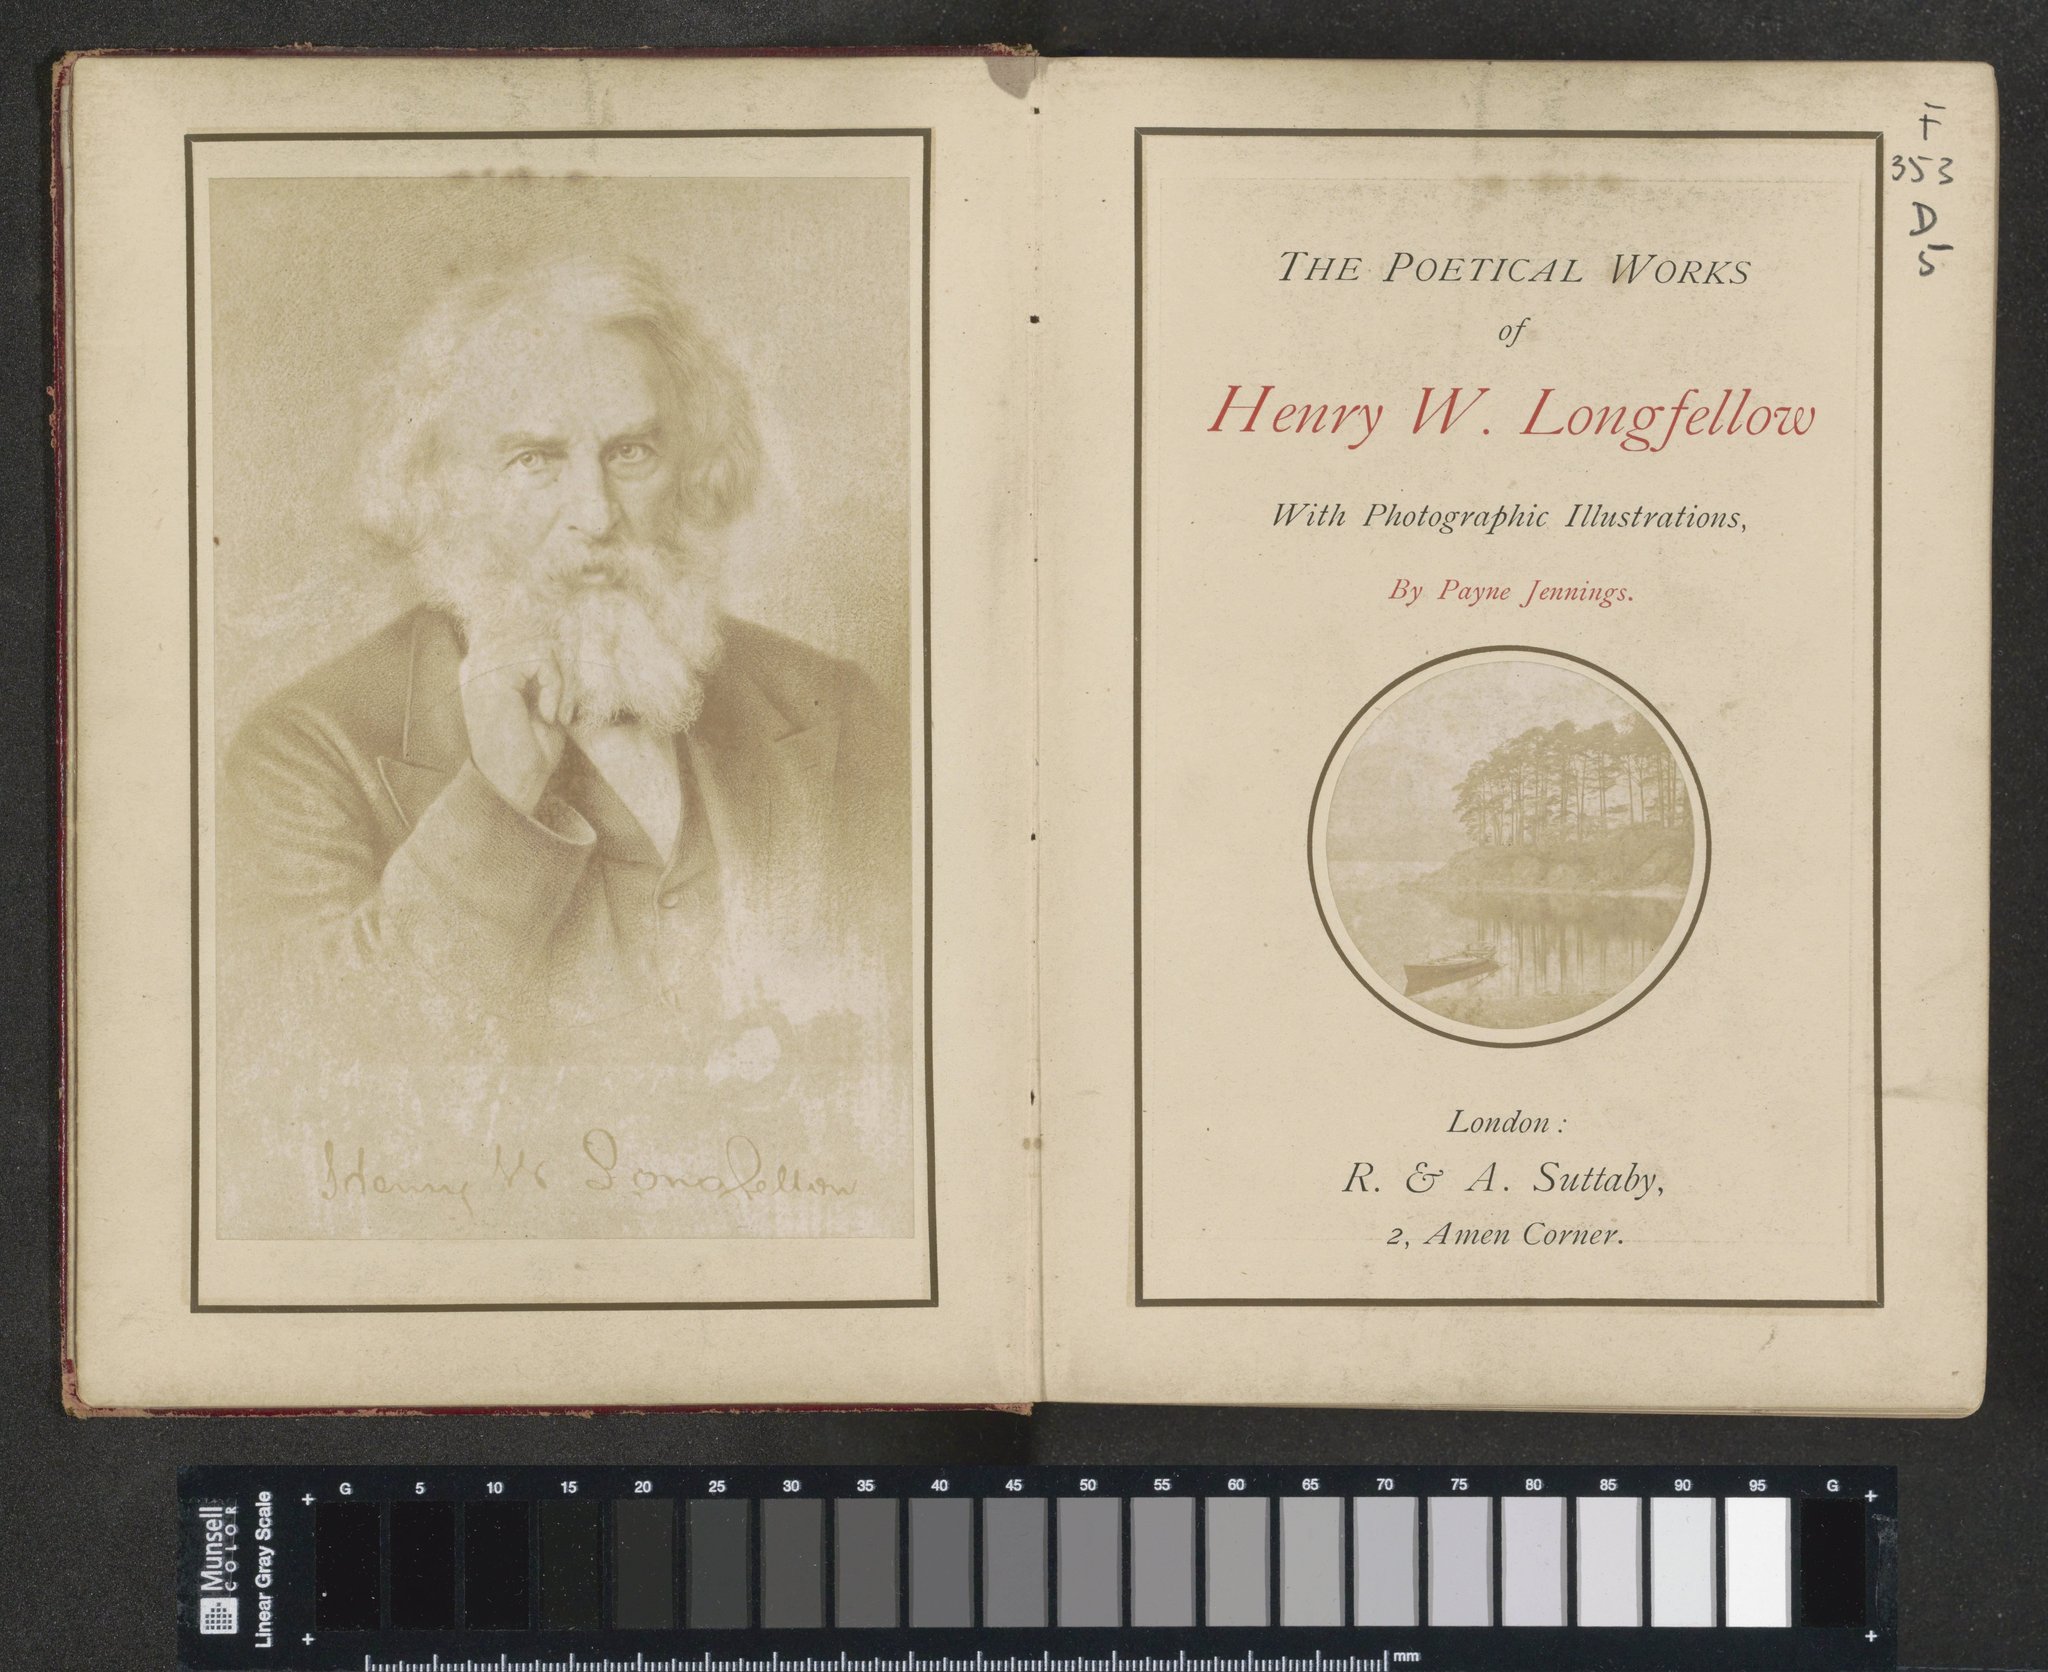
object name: photograph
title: Gezicht op een rivier met een boot en bomen op de waterkant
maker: john payne jennings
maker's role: fotograaf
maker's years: 1843-1926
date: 1867-1877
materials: photographic support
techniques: albumen print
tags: river, rowing-boat, canoe, etc.